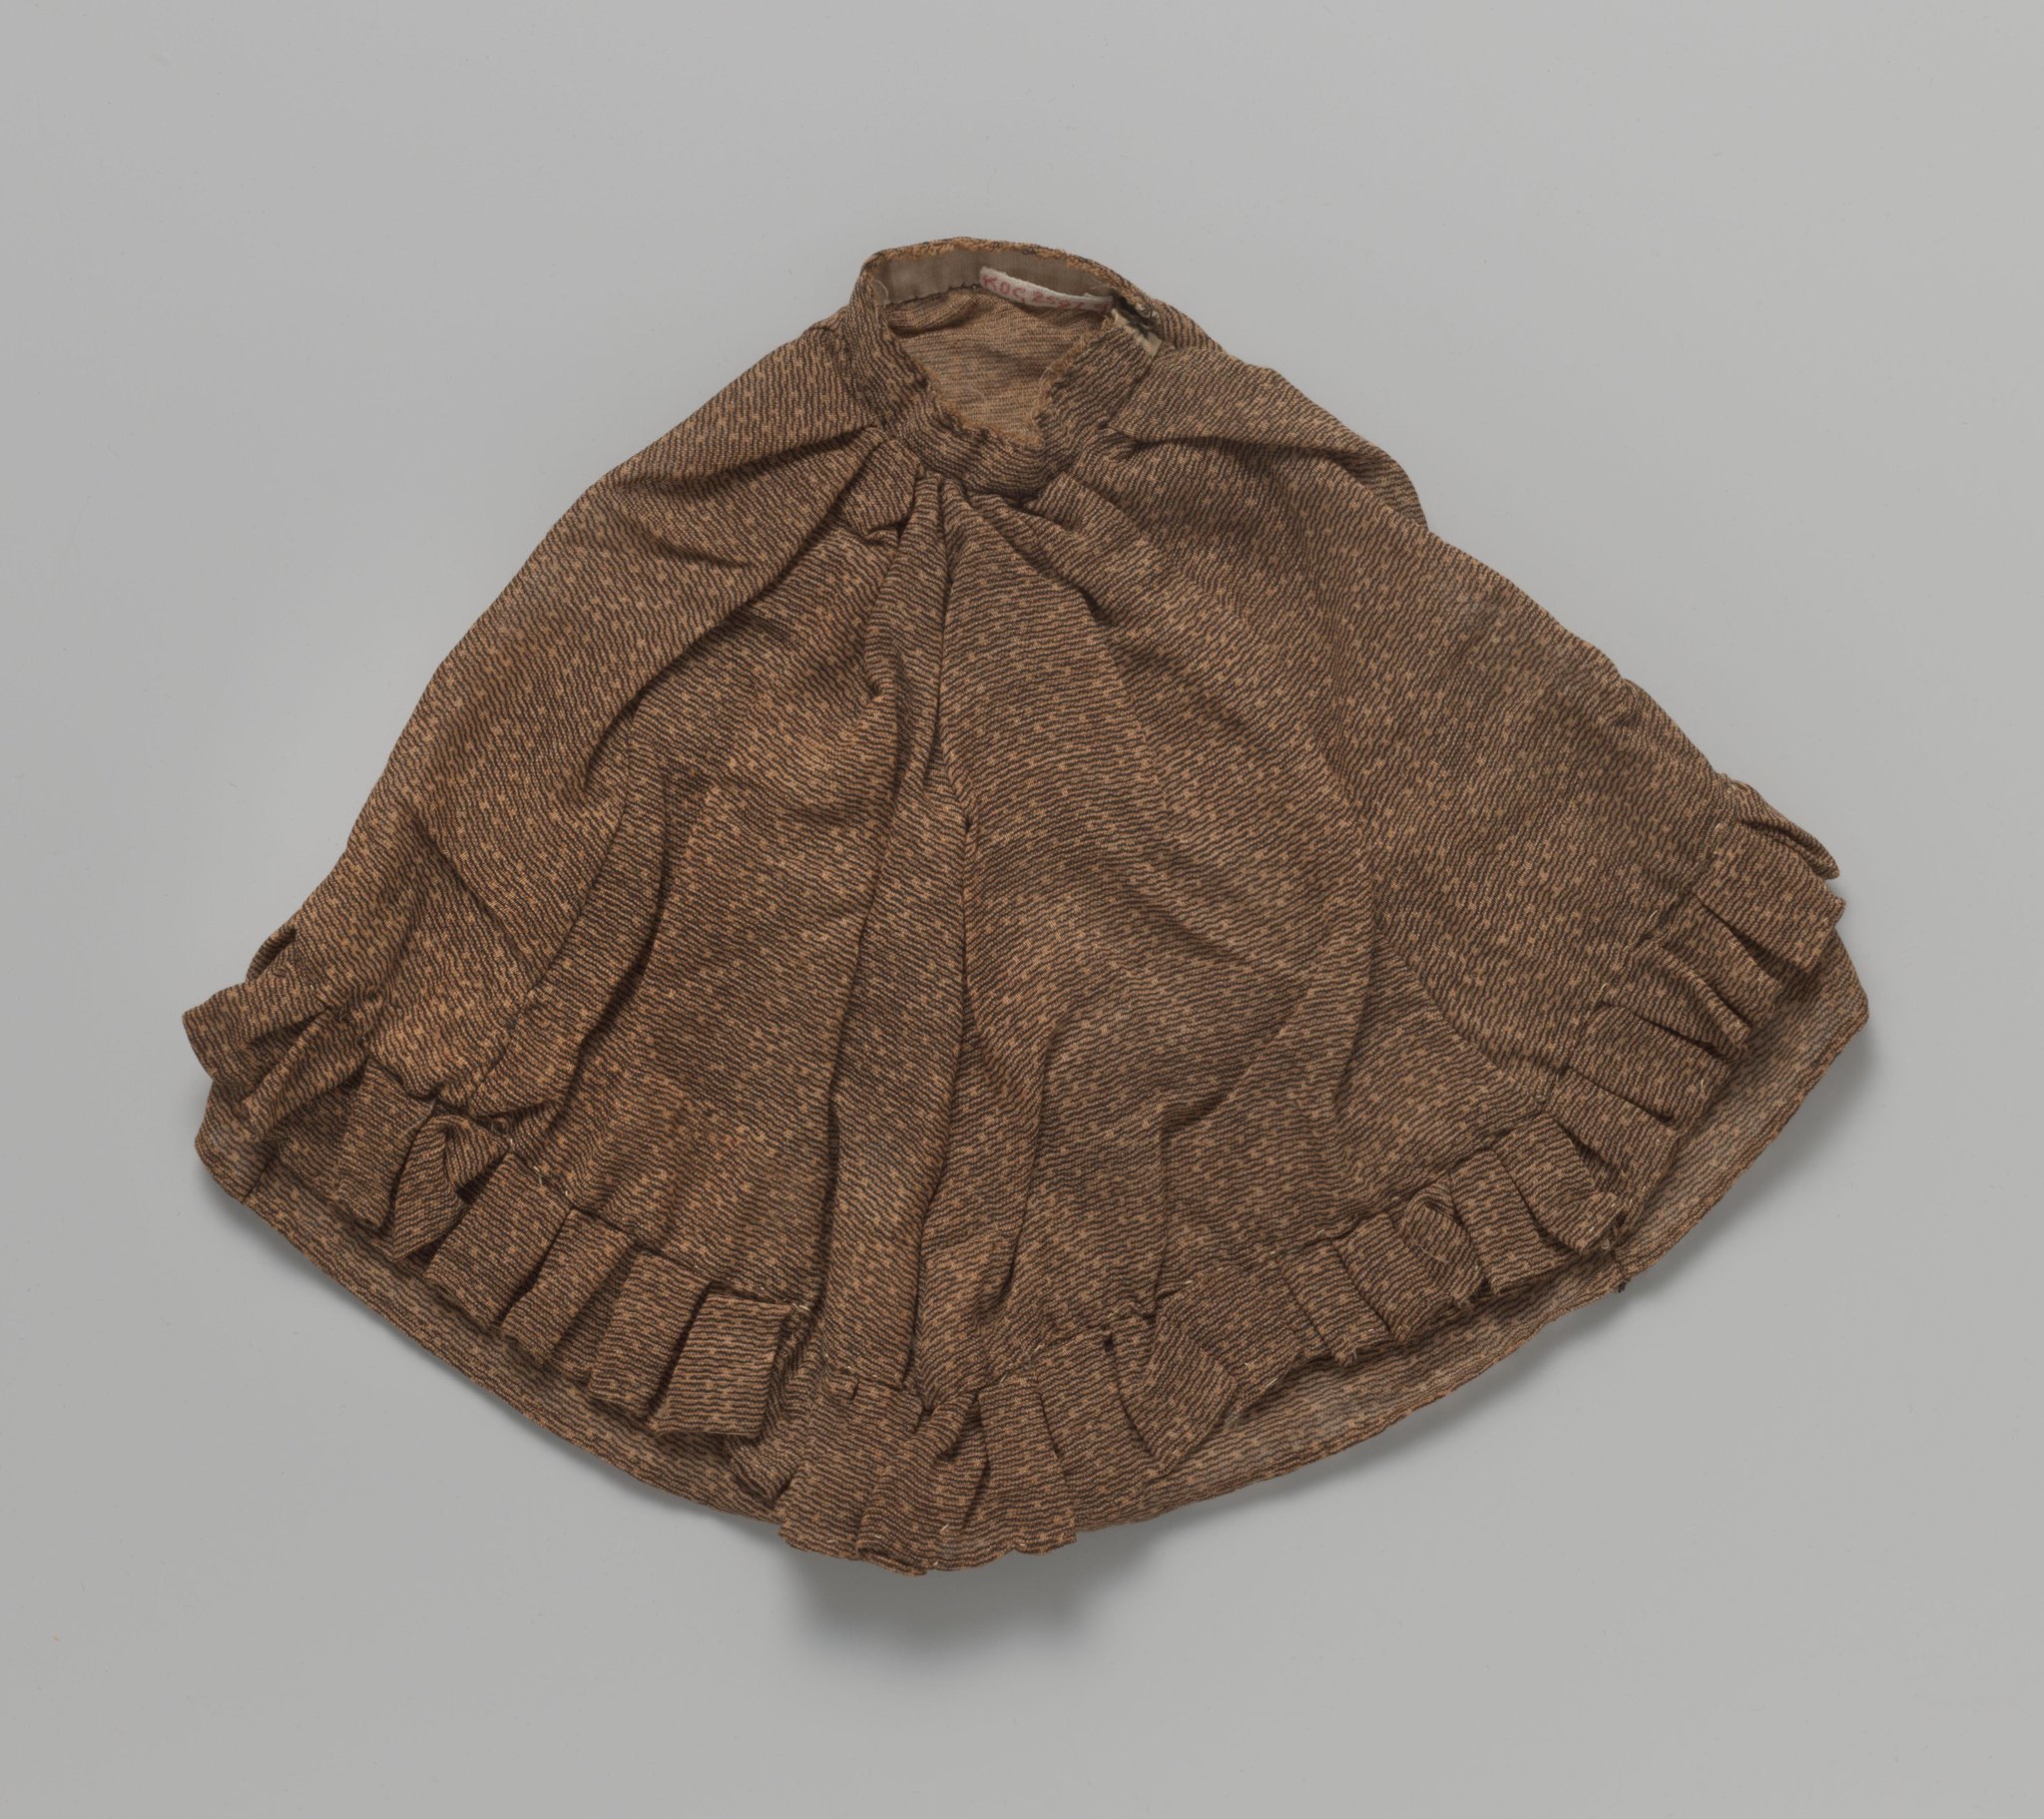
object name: doll's clothing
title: Rok met geplooide volant met aan de voorzijde twee rozetten.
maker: Anonymous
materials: textile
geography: netherlands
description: Rok van beige mousseline met een zwart werkje; geplooide volant met aan de voorzijde twee rozetten van dezelfde stof.